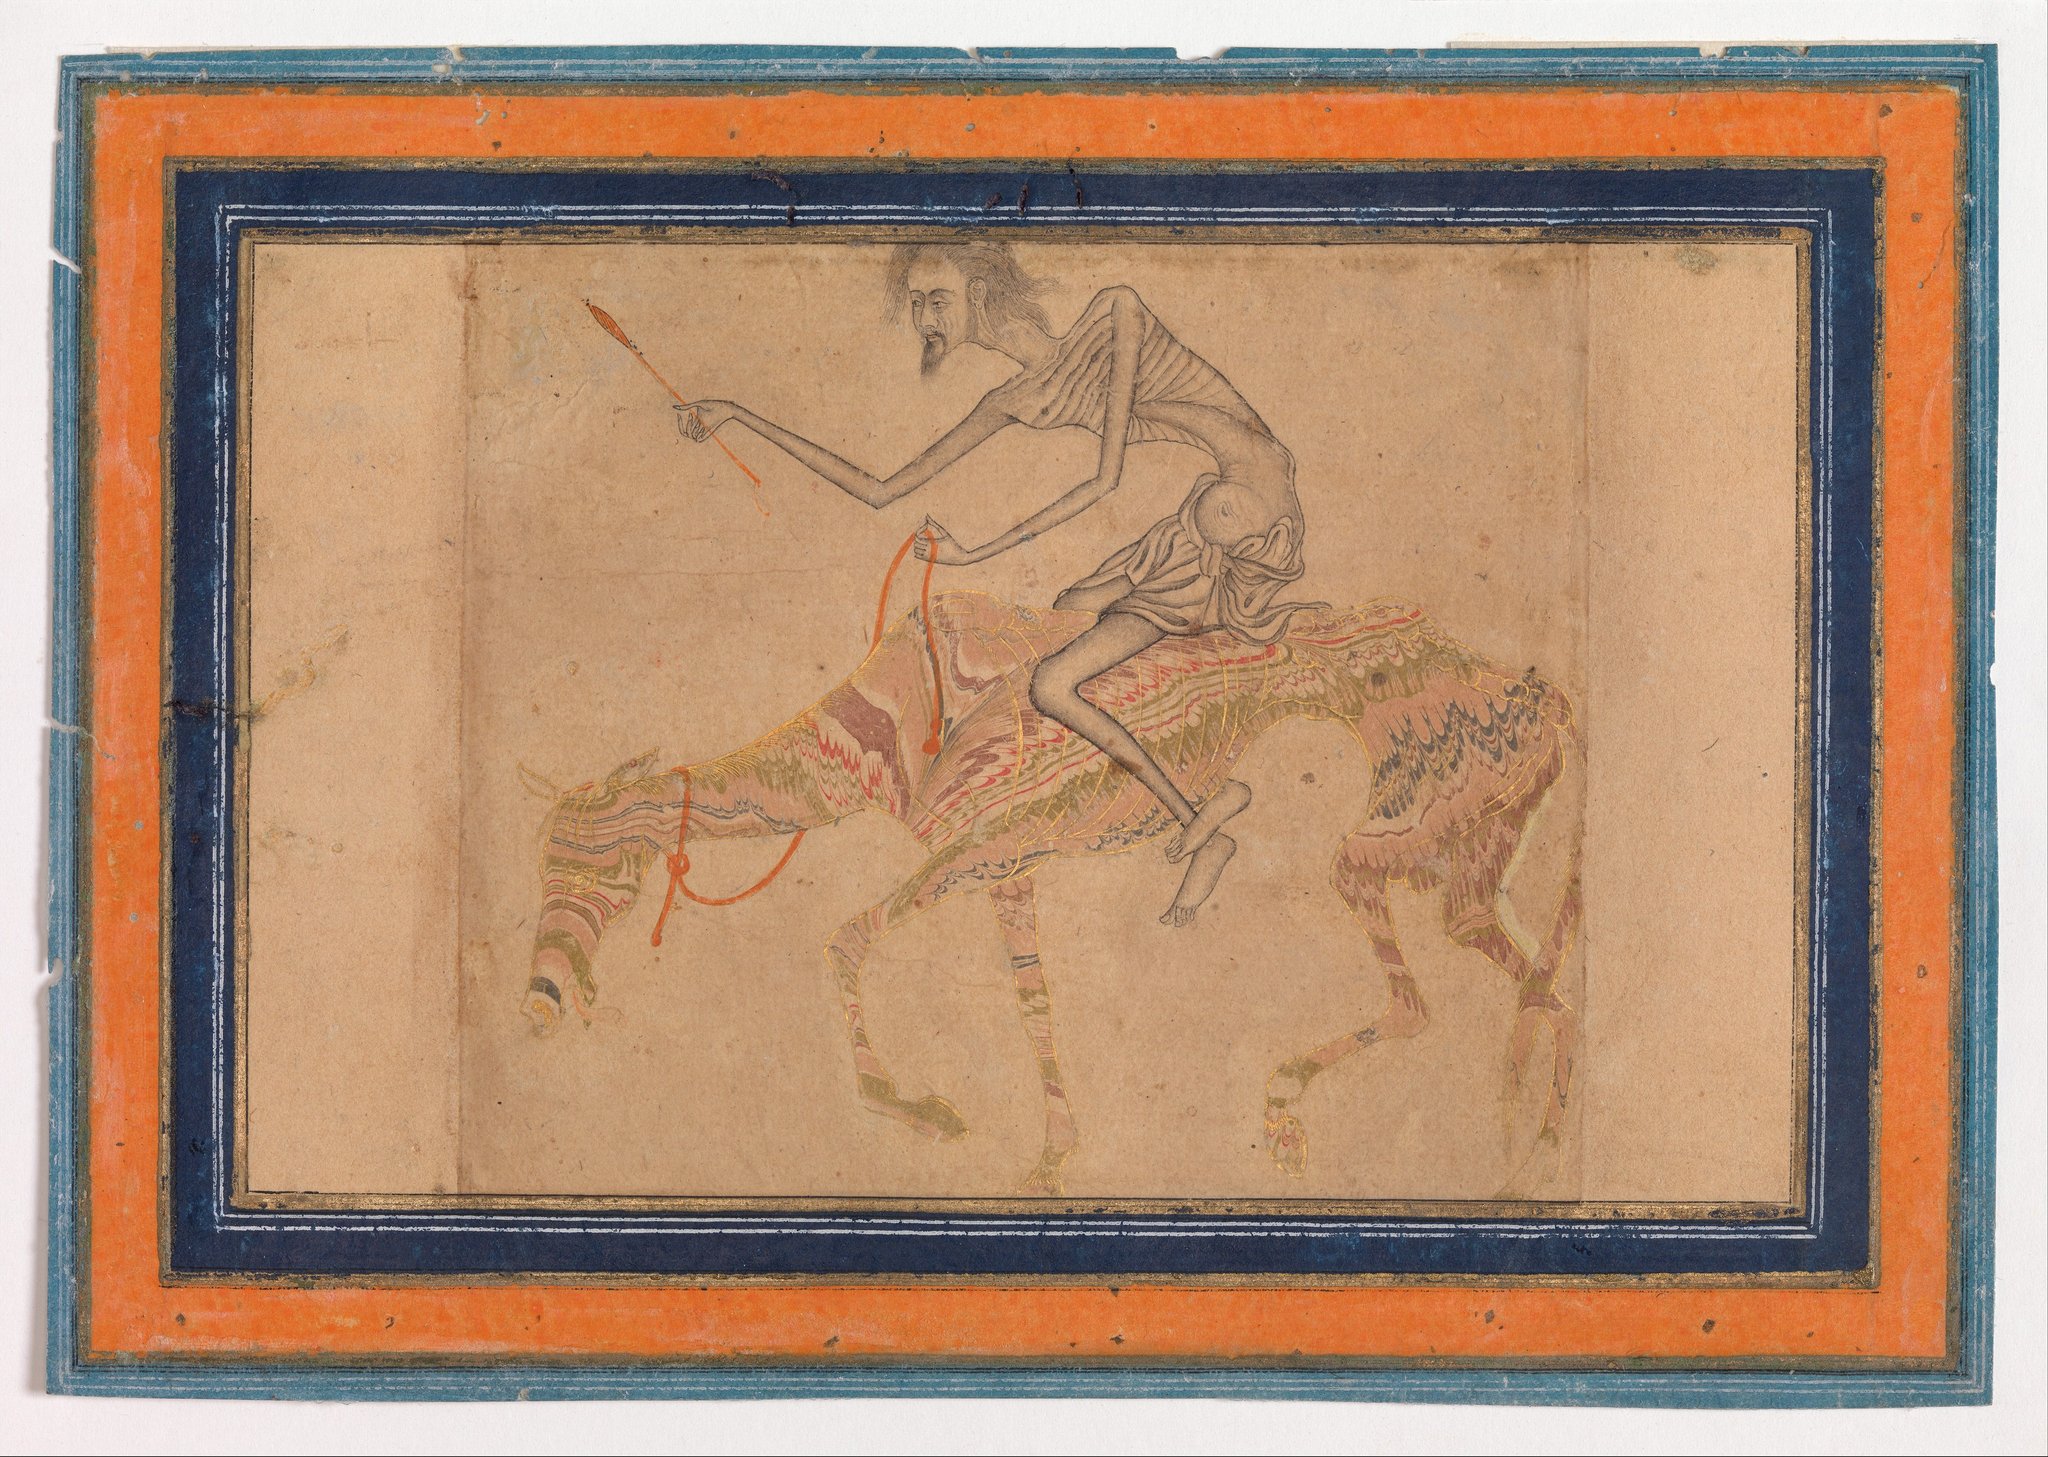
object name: illustrated single work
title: Emaciated Horse and Rider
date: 1625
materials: gold, ink, paper, watercolor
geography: india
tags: men,horses